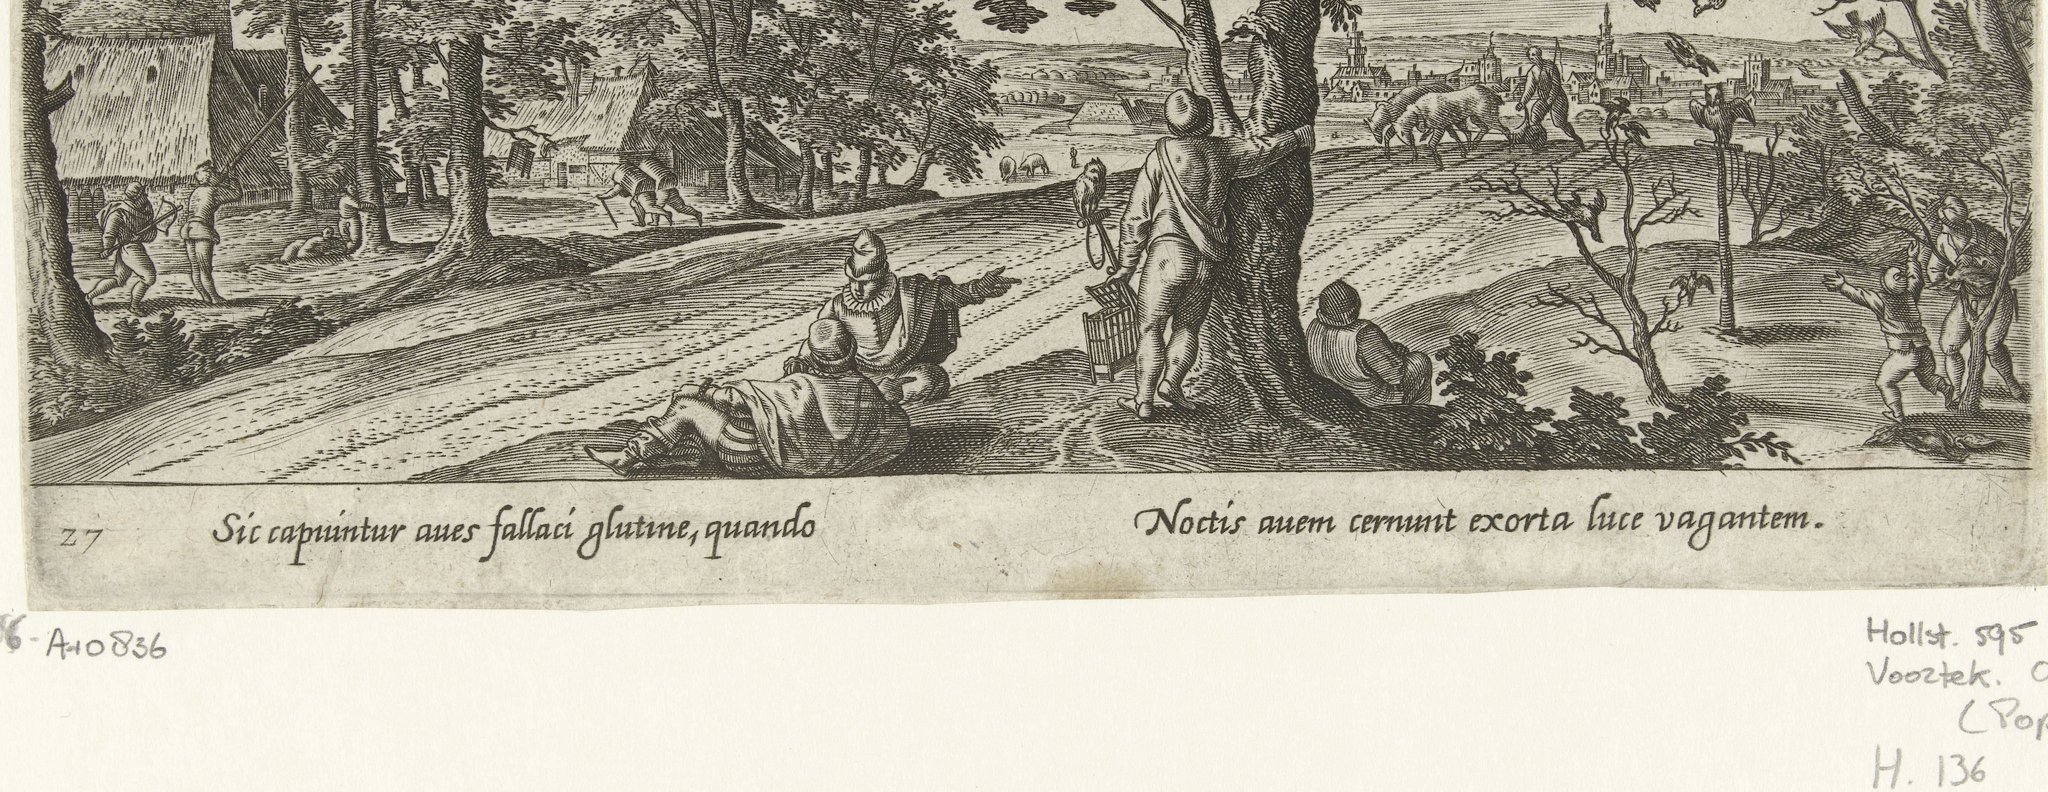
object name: print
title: Venationes, Piscationes et Aucupii Typi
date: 1582-1633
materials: paper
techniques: engraving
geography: antwerp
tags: owls, bird hunting (+ artificial decoy animals, e.g. artificial decoy duck ~ lures (hunting))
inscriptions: collector's mark: Lugt 2228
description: Jagers vangen vogels met behulp van een lokuil. De prent heeft een Latijns onderschrift en maakt deel uit van een serie van 54 prenten.